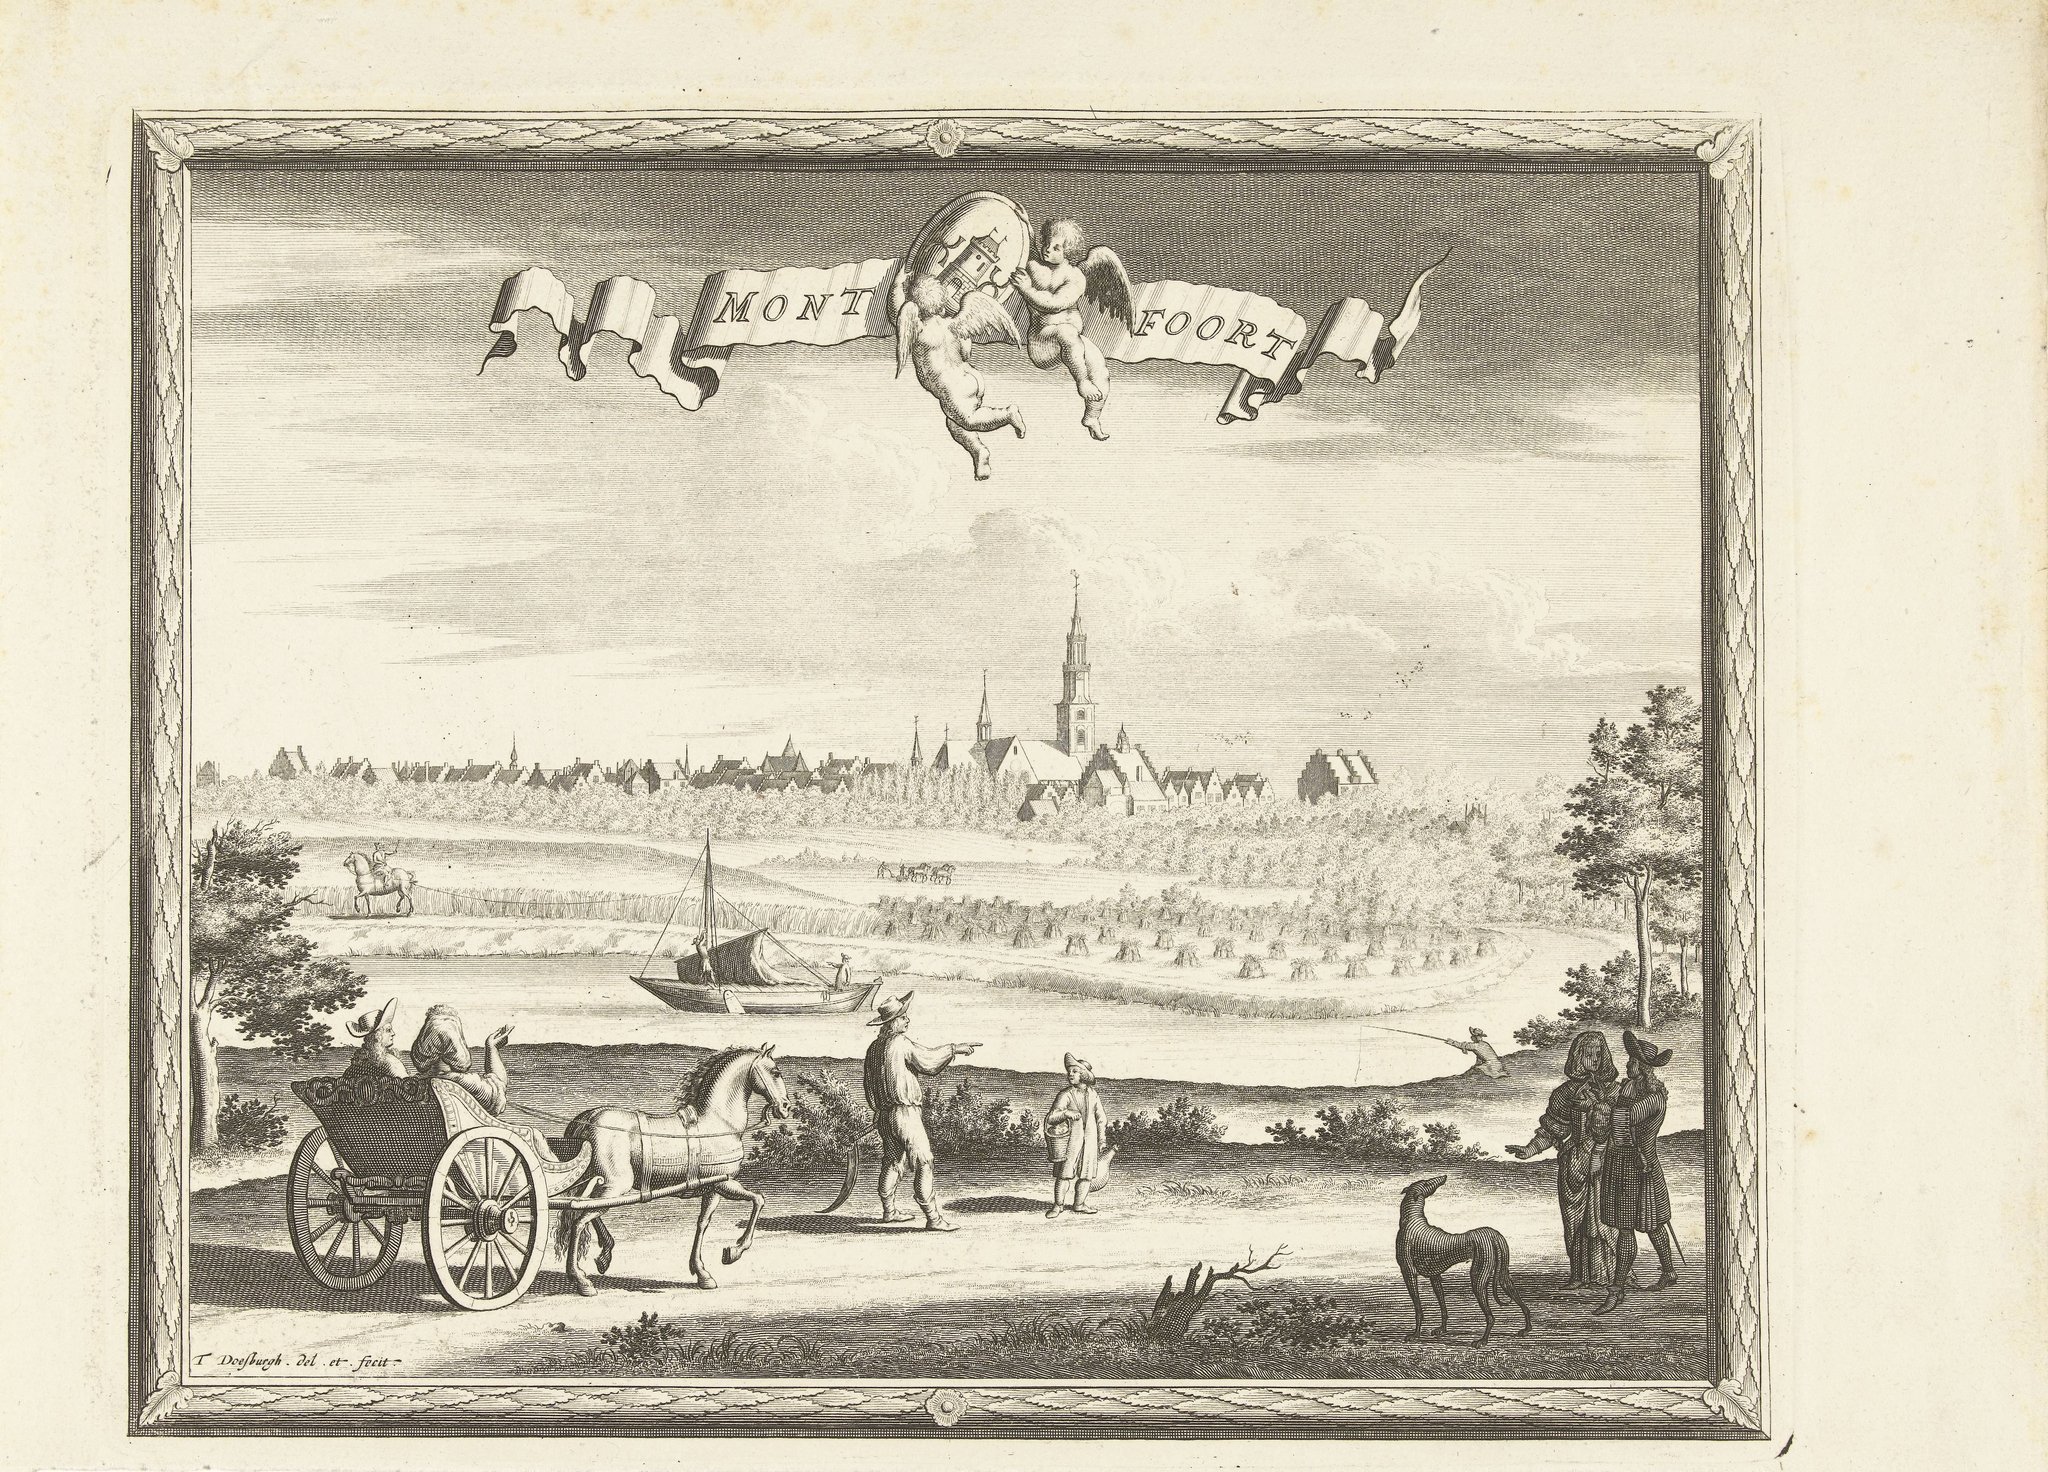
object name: print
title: Gezicht op Montfoort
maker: thomas doesburgh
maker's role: print maker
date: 1692-1714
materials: paper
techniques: engraving, etching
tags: prospect of city, town panorama, silhouette of city